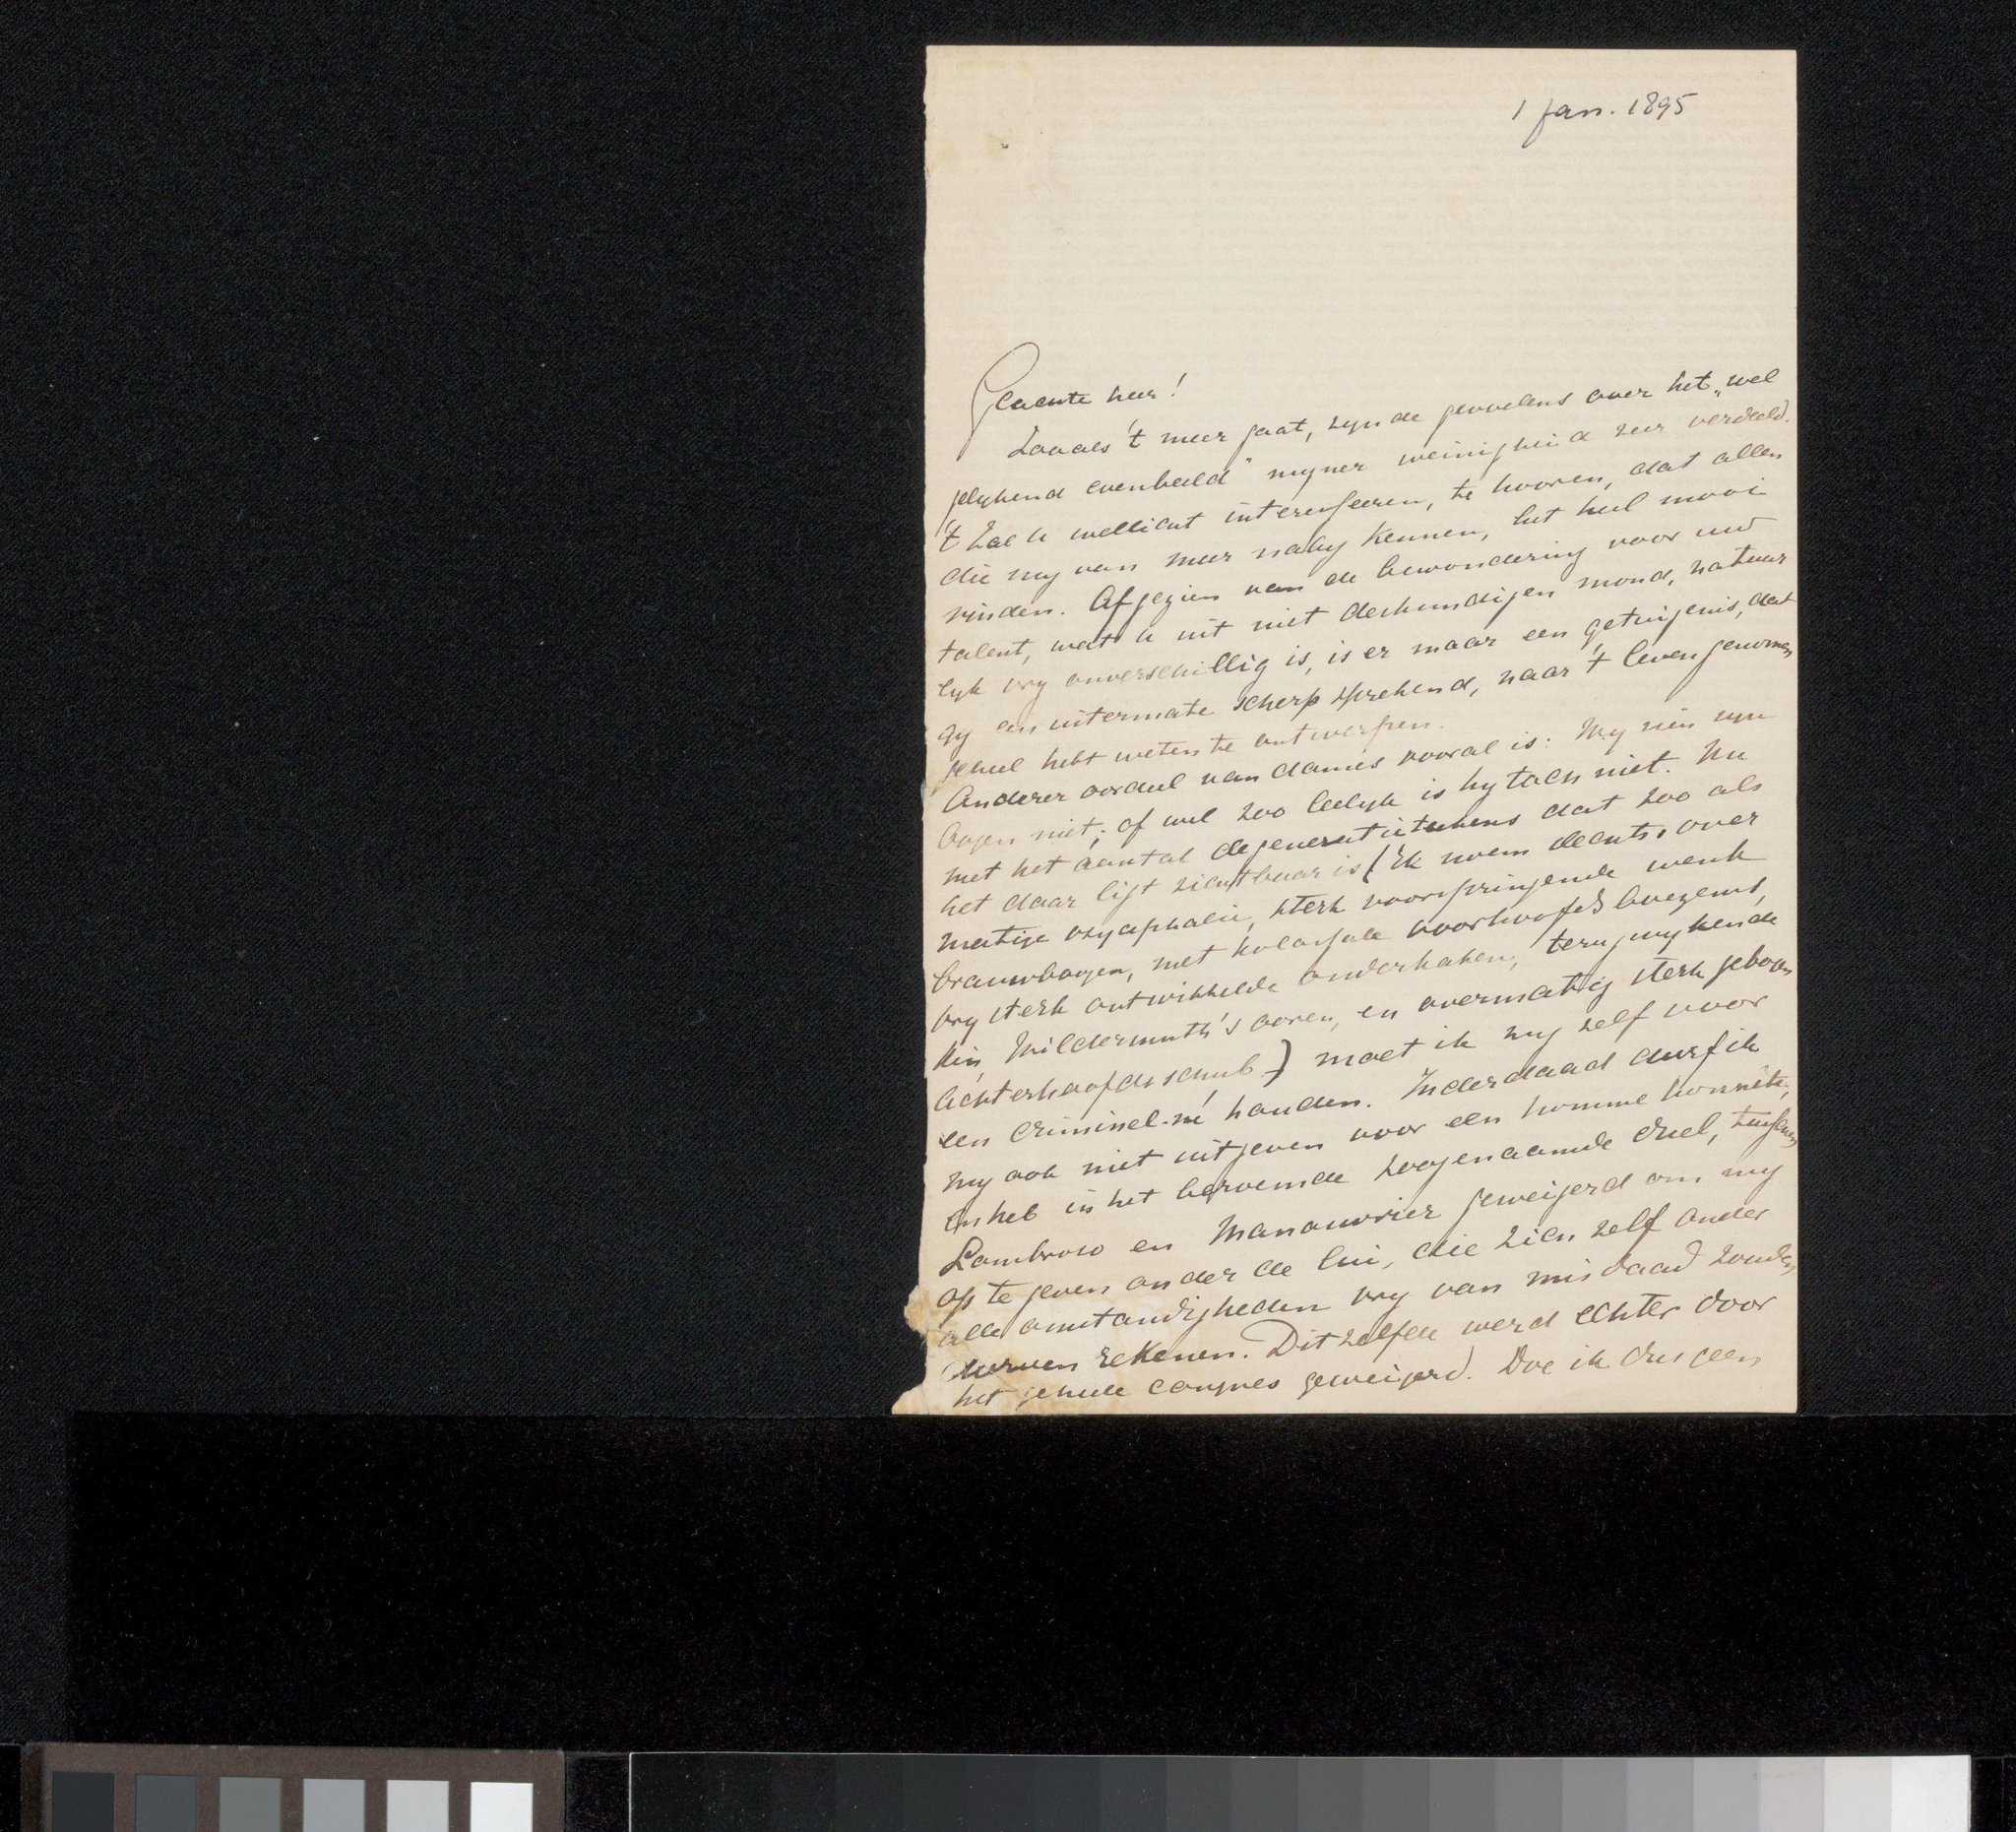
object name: letter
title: Brief aan Jan Veth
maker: cornelis winkler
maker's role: hoogleraar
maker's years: 1855-1941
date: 1895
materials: ink, paper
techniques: pen, writing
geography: utrecht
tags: dordrecht, amsterdam, painter, print maker, draughtsman, designer, jan veth, painting (including book-illumination, miniature-painting), historical persons (portraits and scenes from the life)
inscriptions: collector's mark: ‘RPK’